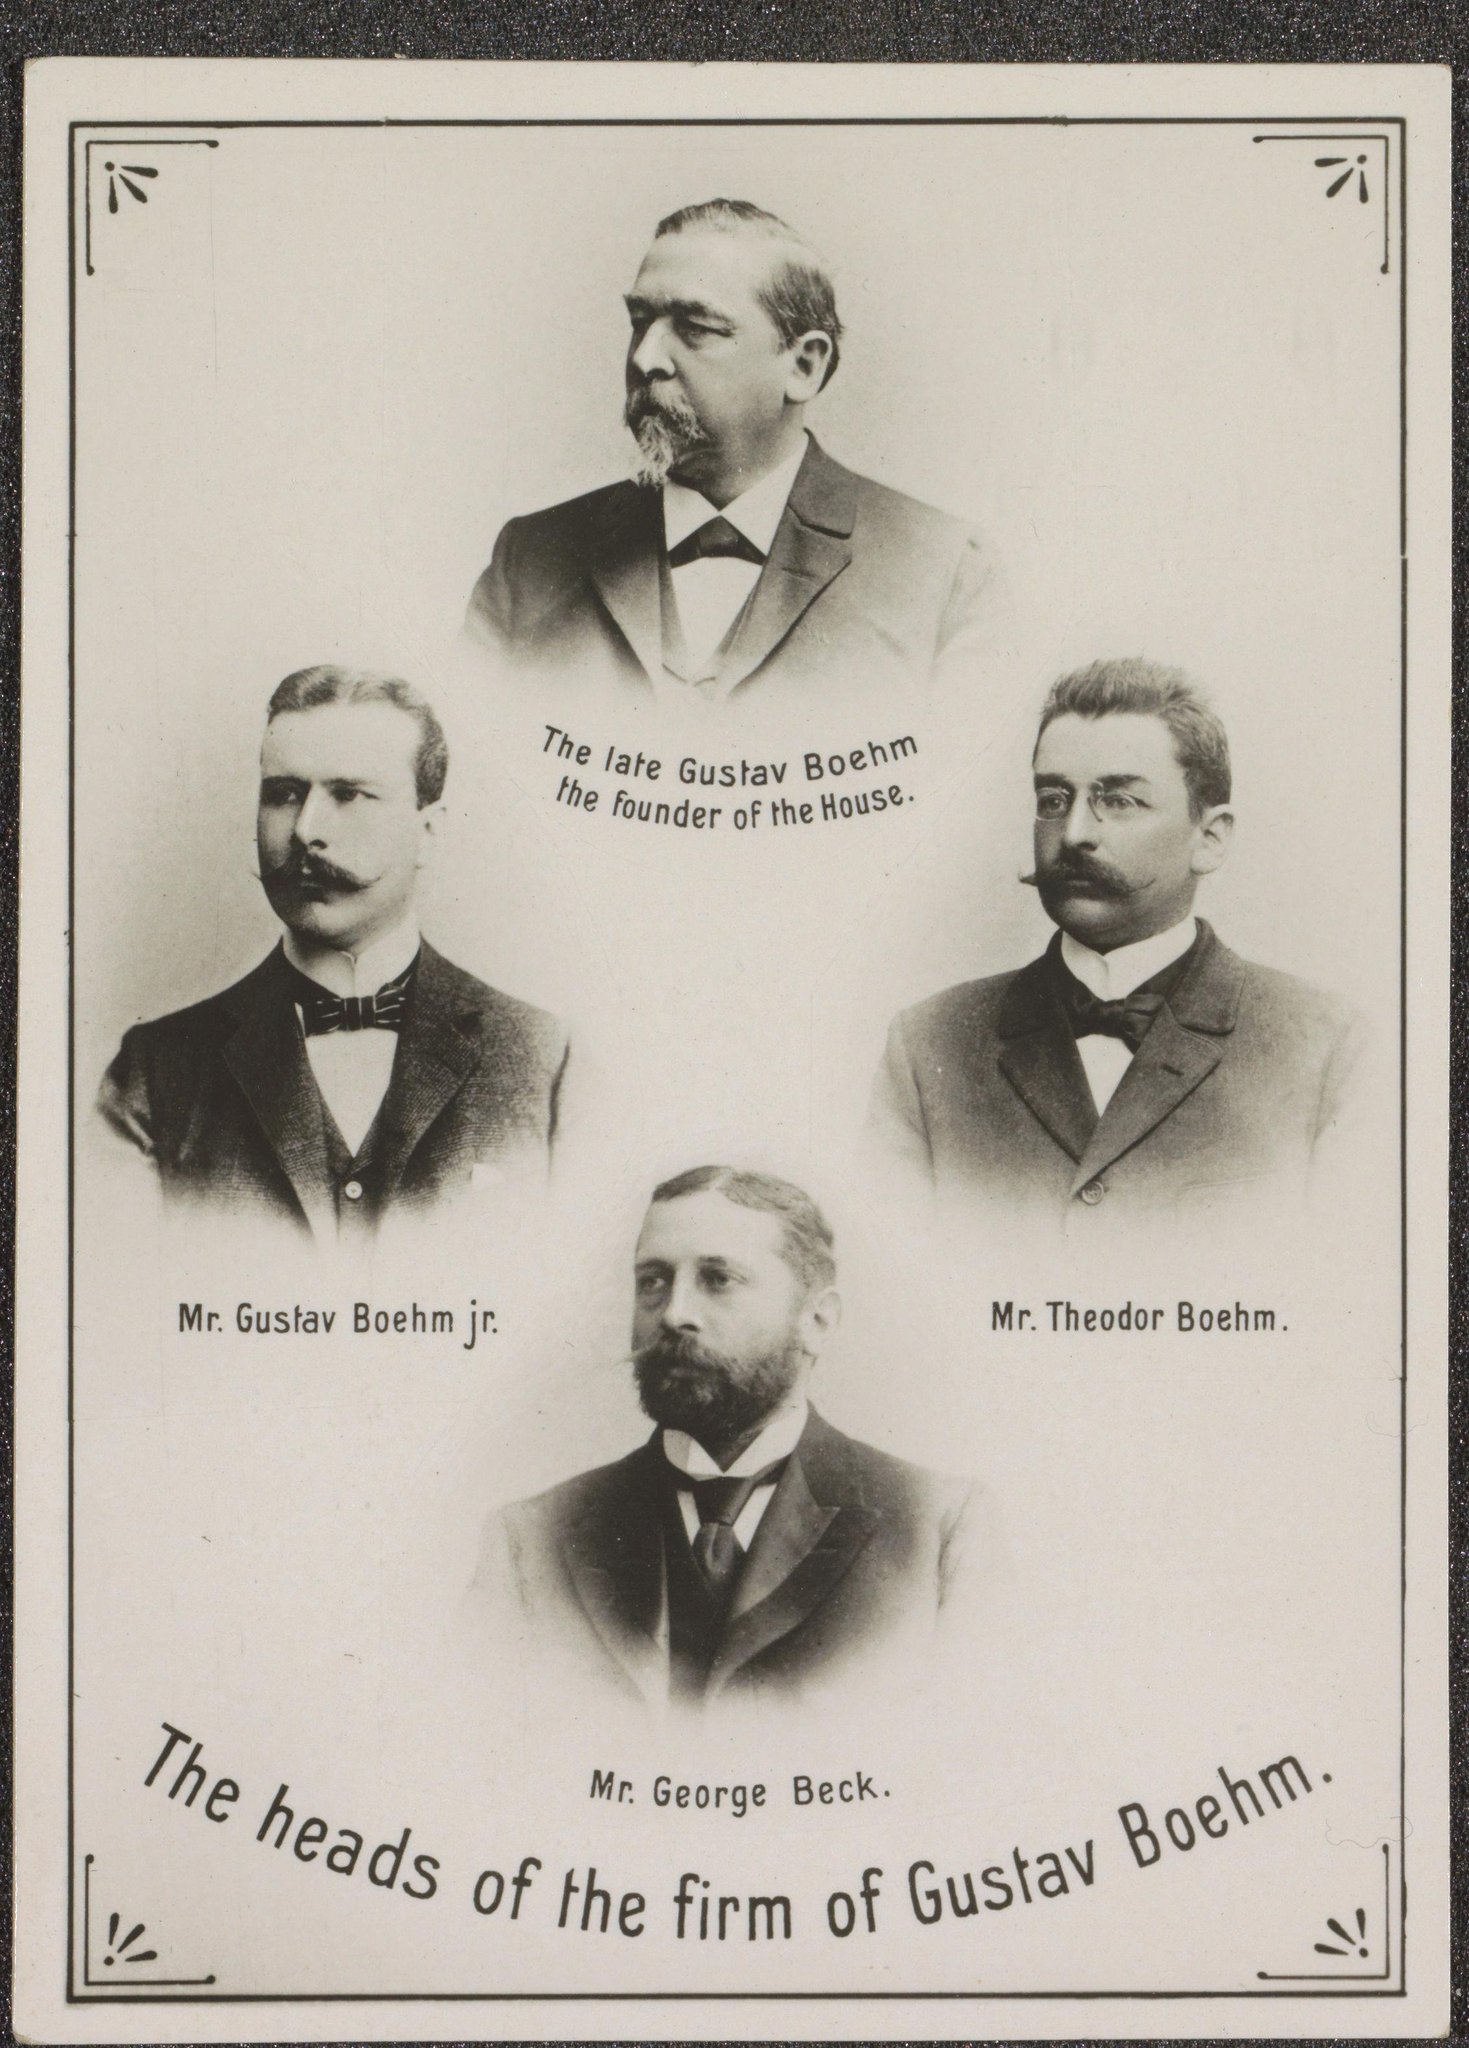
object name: photomontage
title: Fotomontage van de directieleden van de firma van Gustav Boehm: grondlegger wijlen Gustav Boehm sr., Gustav Boehm jr., Theodor Boehm en George Beck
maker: Anonymous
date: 1899-1901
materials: paper, photographic support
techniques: gelatin silver print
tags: painter, manufacturer, gustav boehm (junior), director, boss (in modern industry)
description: Onderdeel van Foto's van de wereldreis van Gustav Boehm 1899-1901, serie 2.